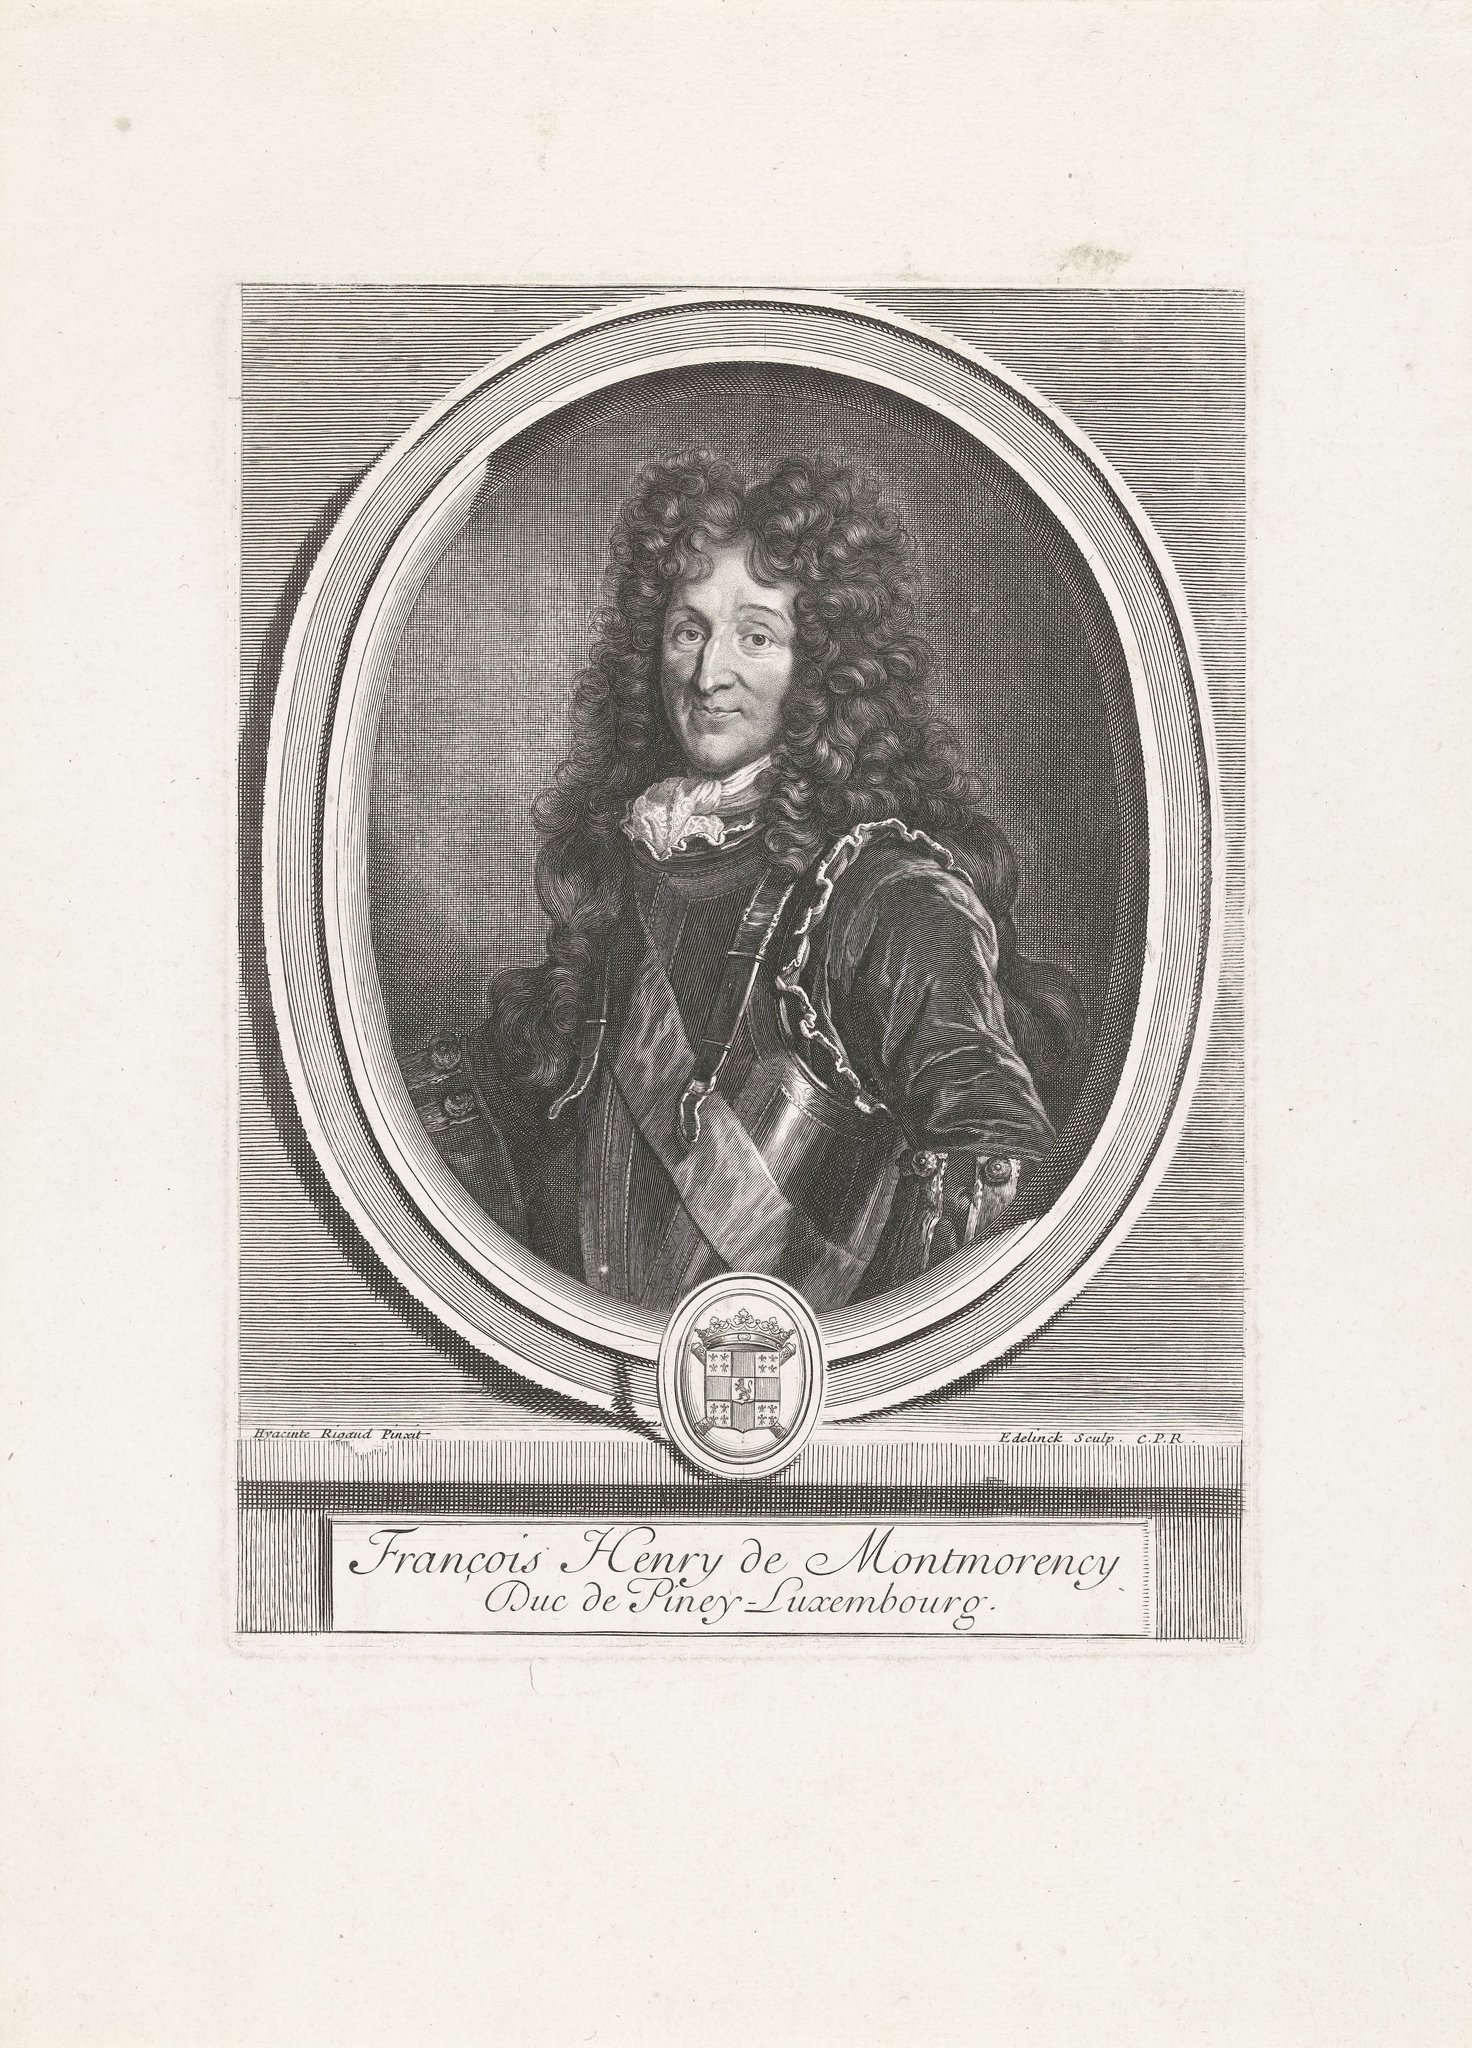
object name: print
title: Portret van François Henri de Montmorency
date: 1666-1707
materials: paper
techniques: engraving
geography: france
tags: paris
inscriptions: collector's mark: Lugt 240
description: Portret van de Franse maarschalk François Henri de Montmorency-Bouteville, hertog van Piney- Luxembourg (1628-1695). Afgebeeld in ovale omlijsting met wapen.